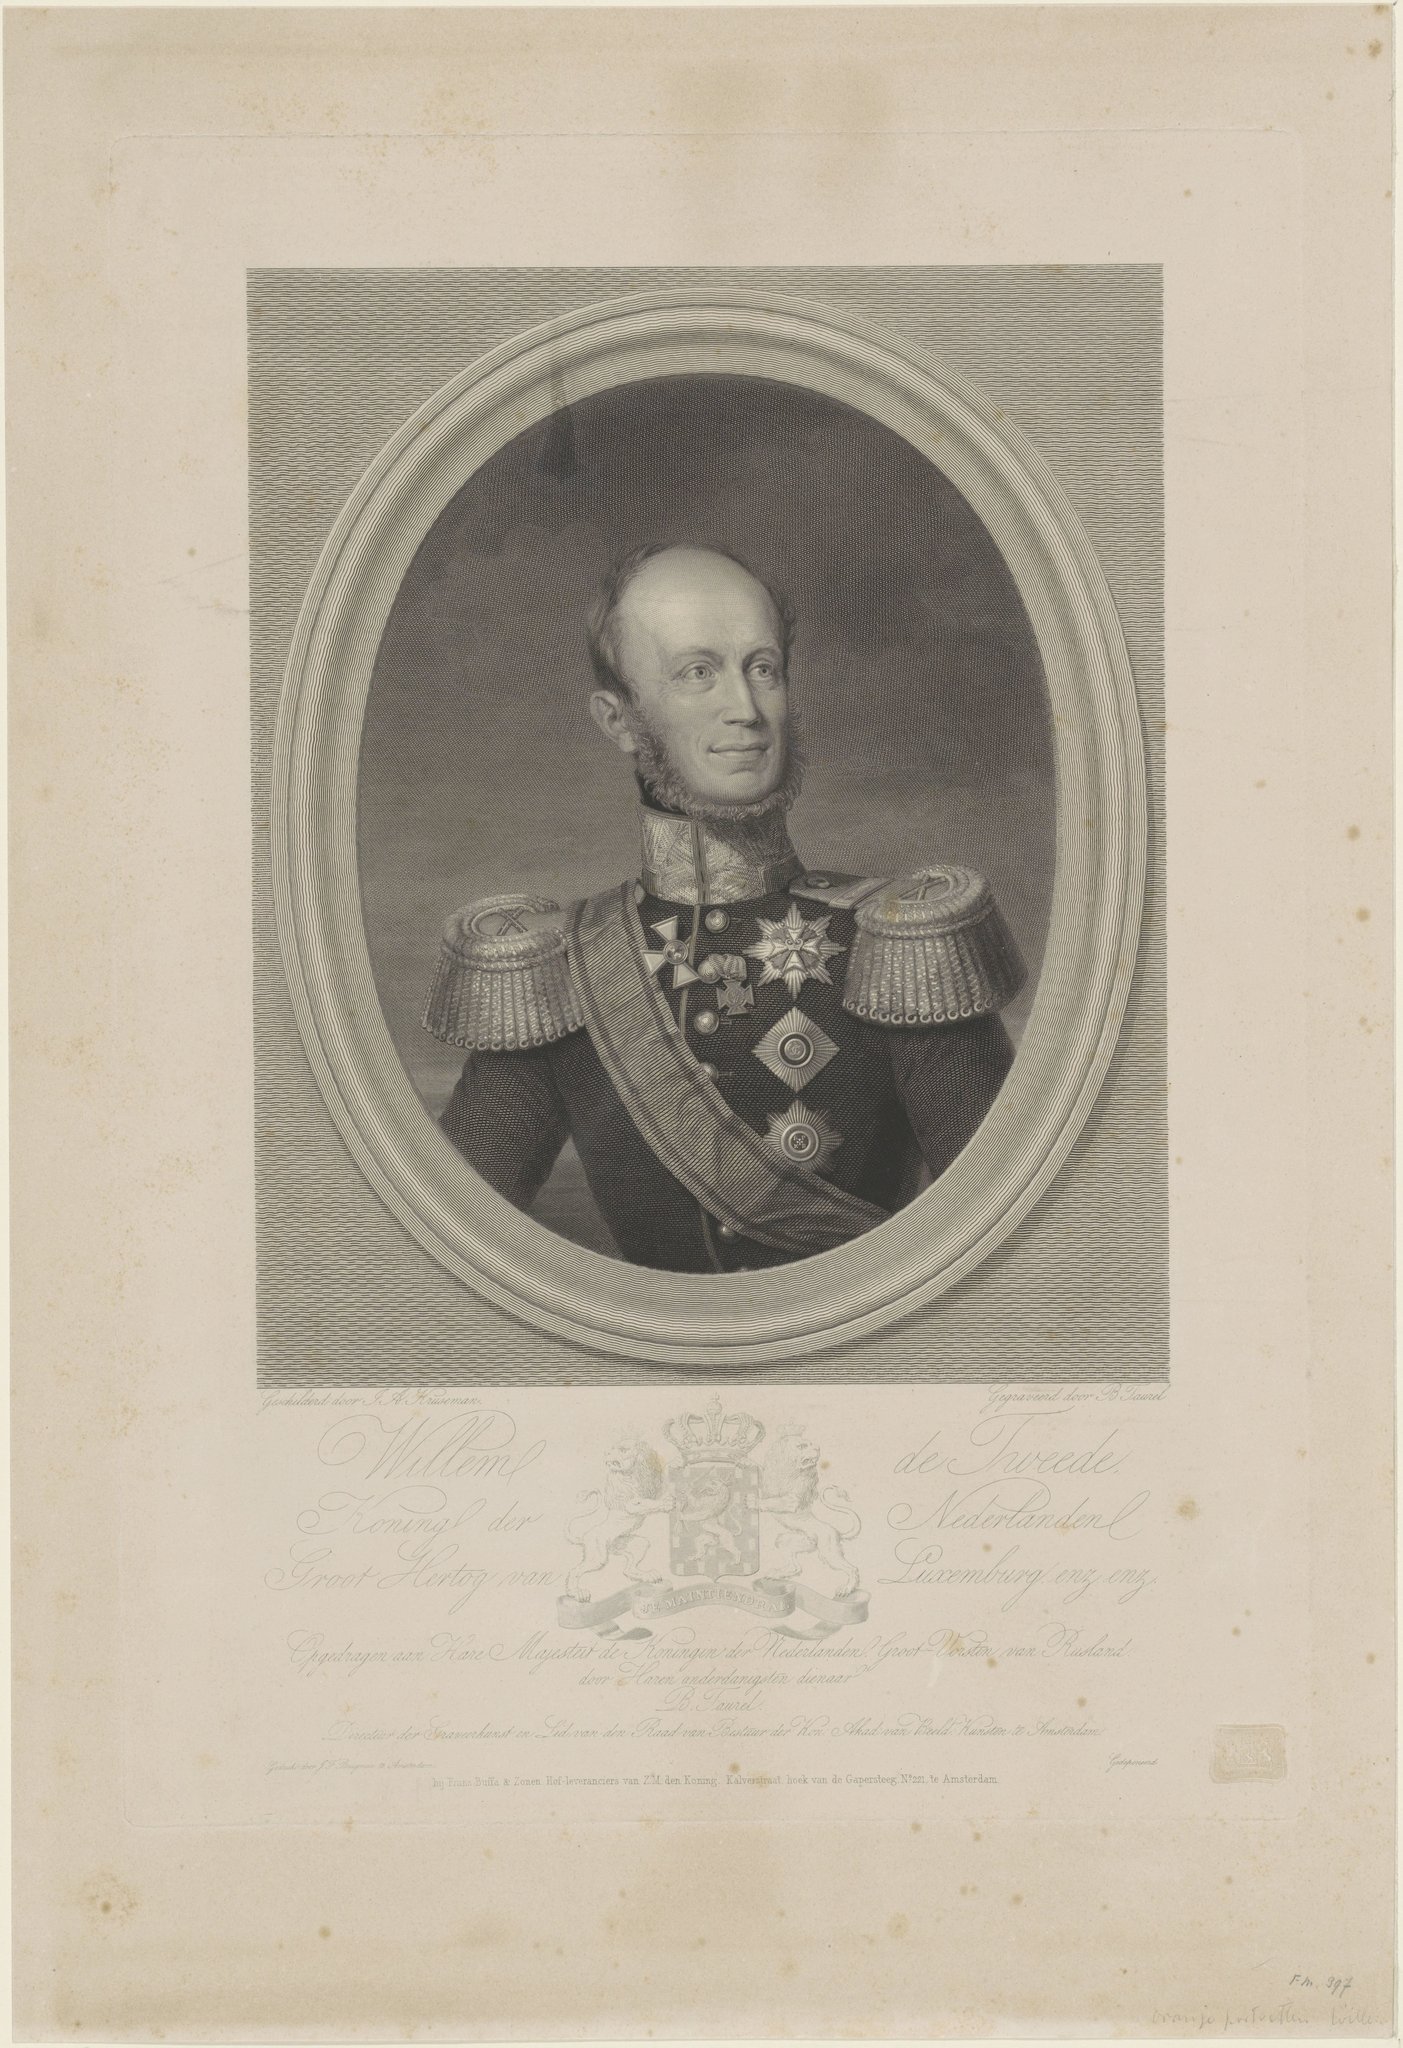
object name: print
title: Portret van Willem II, koning der Nederlanden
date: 1840-1853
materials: paper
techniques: engraving, etching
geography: amsterdam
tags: william ii of the netherlands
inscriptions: check stamp: ‘François Buffa & Fils’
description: Portret van Willem II in een ovaal. Midden onder zijn wapen met een kroon en twee leeuwen. Daaronder op een banderol zijn geslachtsspreuk. In de ondermarge zijn naam en titels.